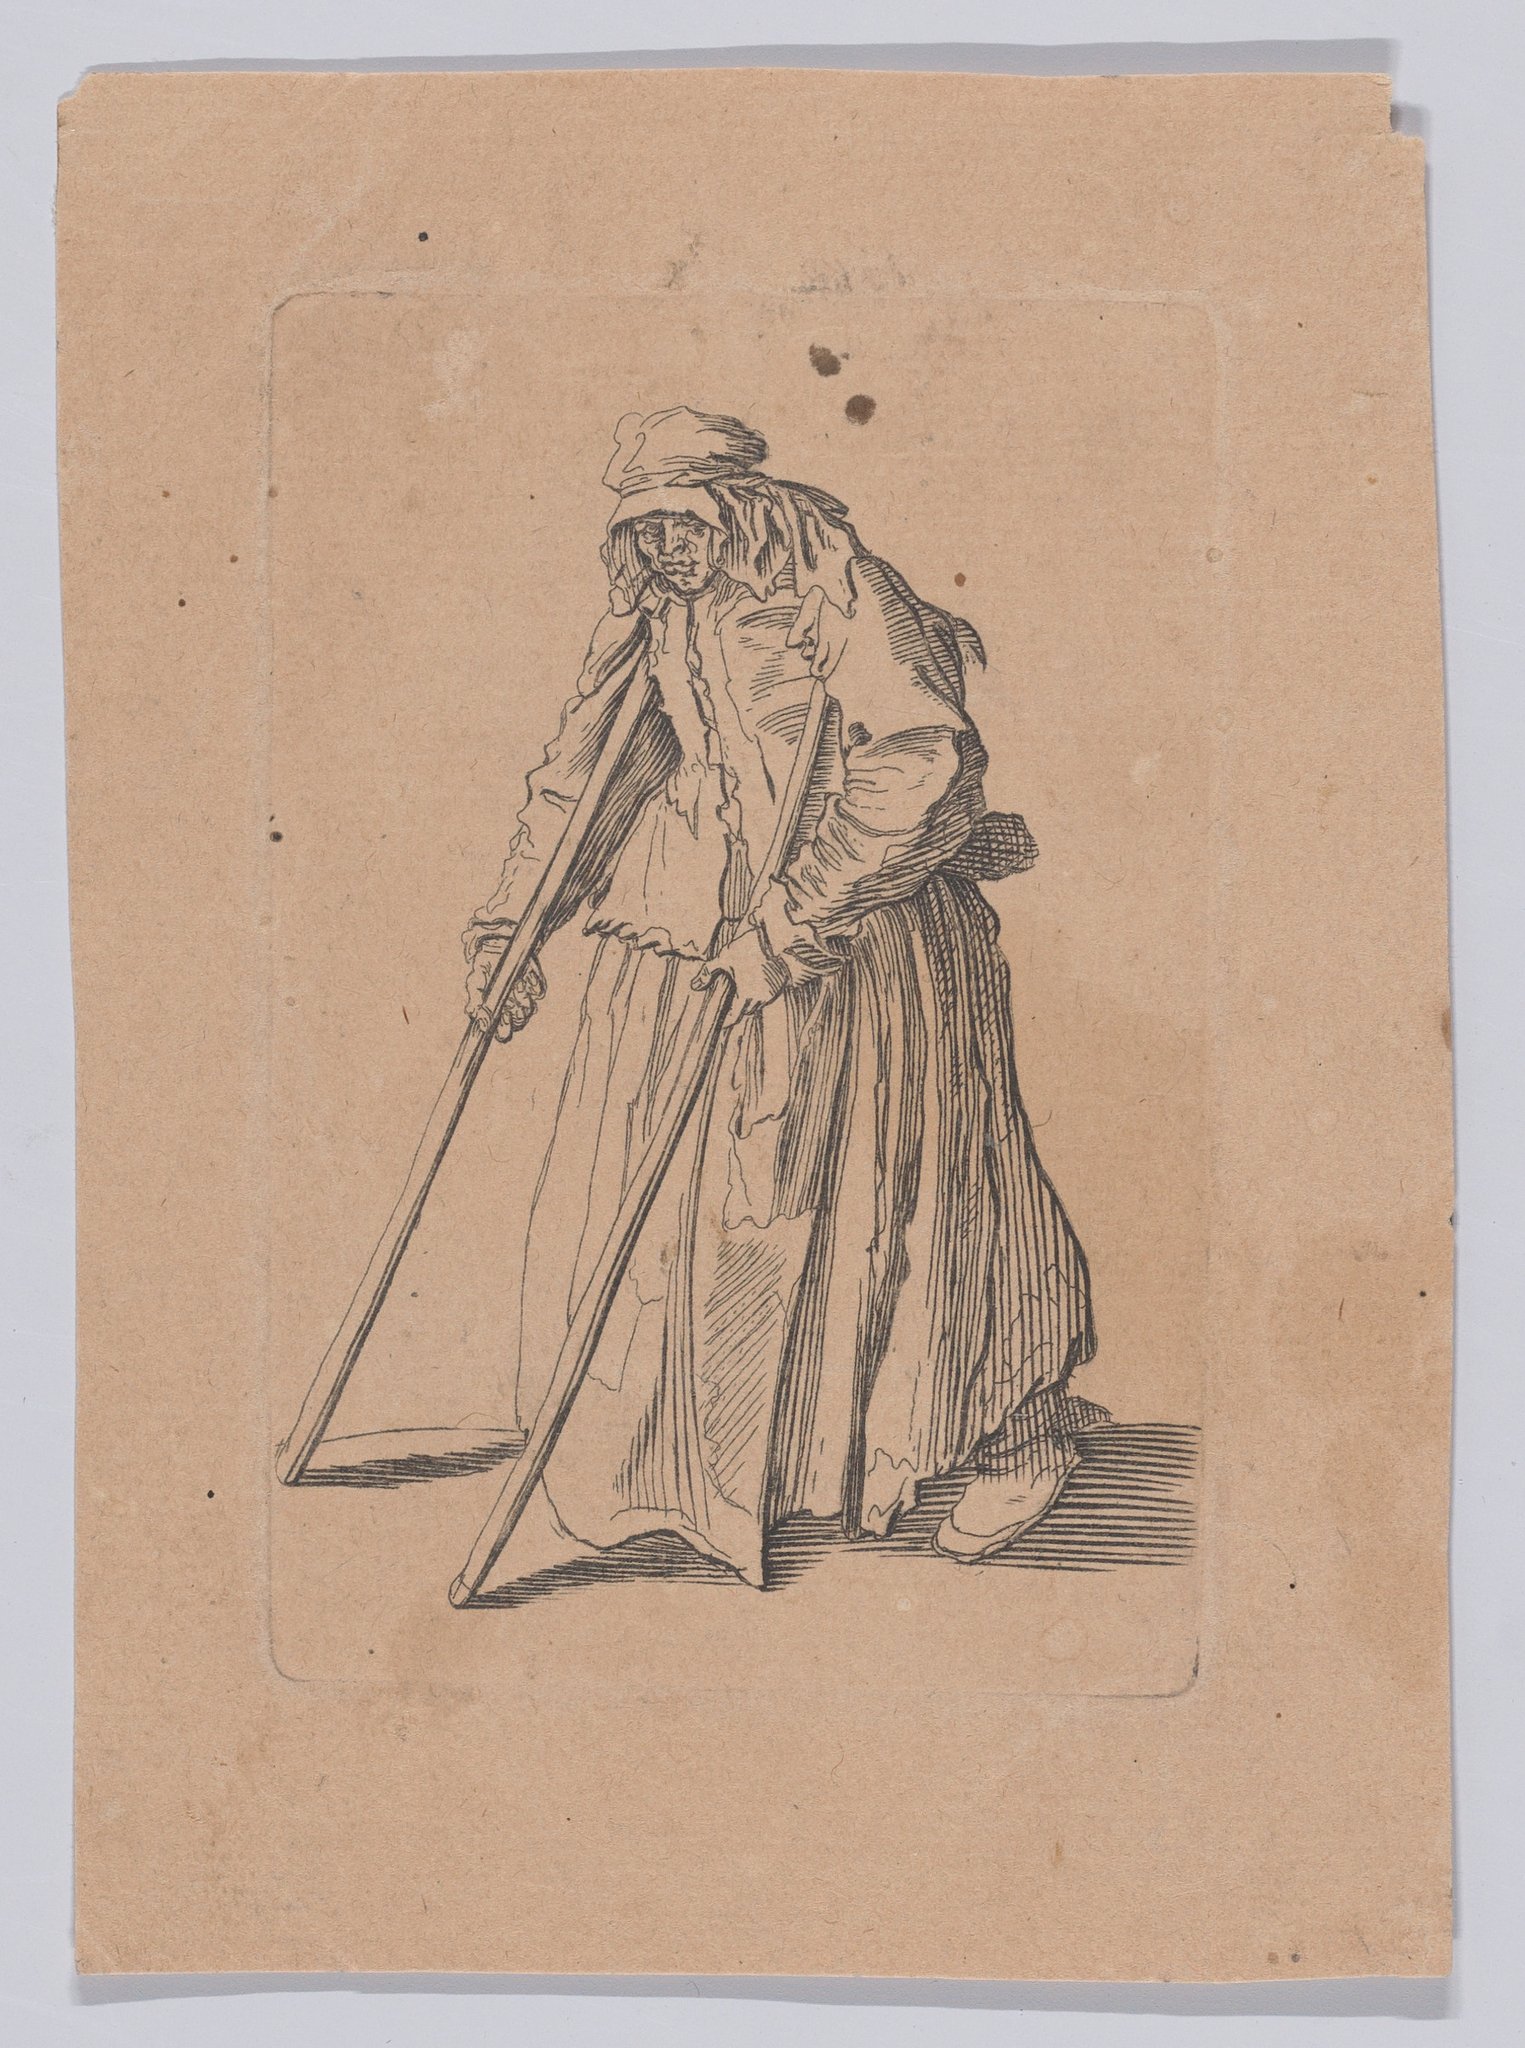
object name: print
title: Reverse and Reduced Copy of La Mendiante aux Béquilles (The Female Beggar with Crutches), from "Les Gueux suite appelée aussi Les Mendiants, Les Baroni, ou Les Barons" (The Beggars, also called the Barons)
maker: Anonymous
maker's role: artist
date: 1601-1700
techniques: etching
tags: women